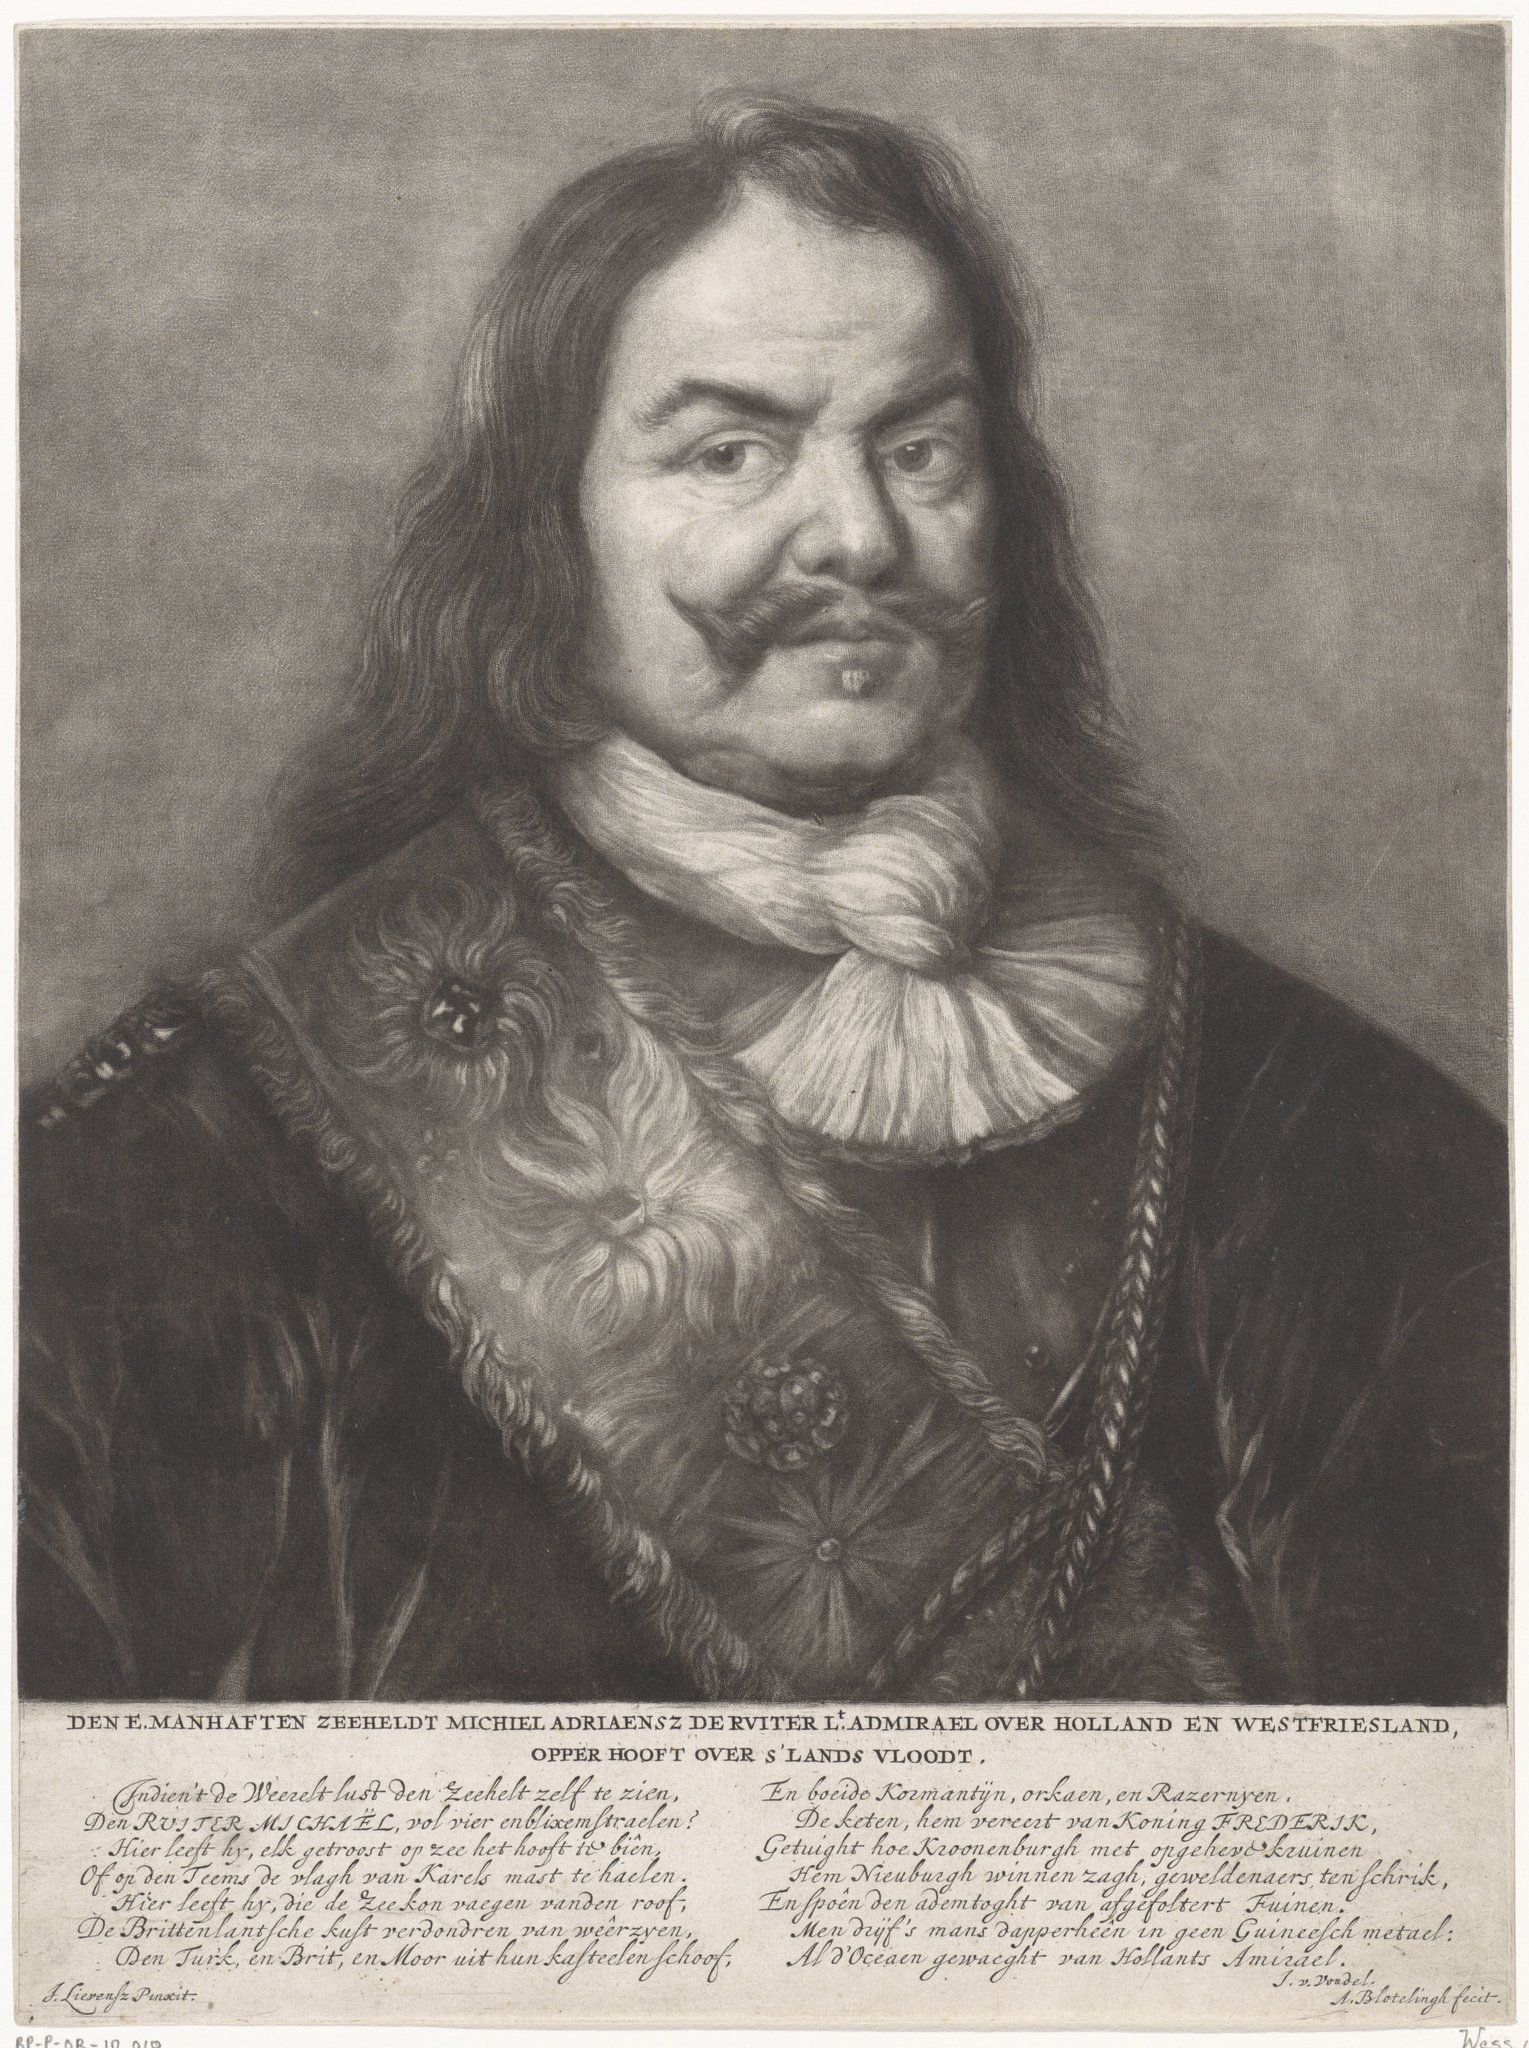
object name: print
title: Portret van Michiel Adriaenszoon de Ruyter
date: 1652-1690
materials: paper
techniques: engraving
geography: amsterdam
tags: flushing, michiel adriaenszoon de ruyter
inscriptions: collector's mark: Lugt 2228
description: Portret van admiraal Michiel Adriaenszoon de Ruyter. Onder het portret een lofdicht door Vondel over zijn heldendaden op zee.